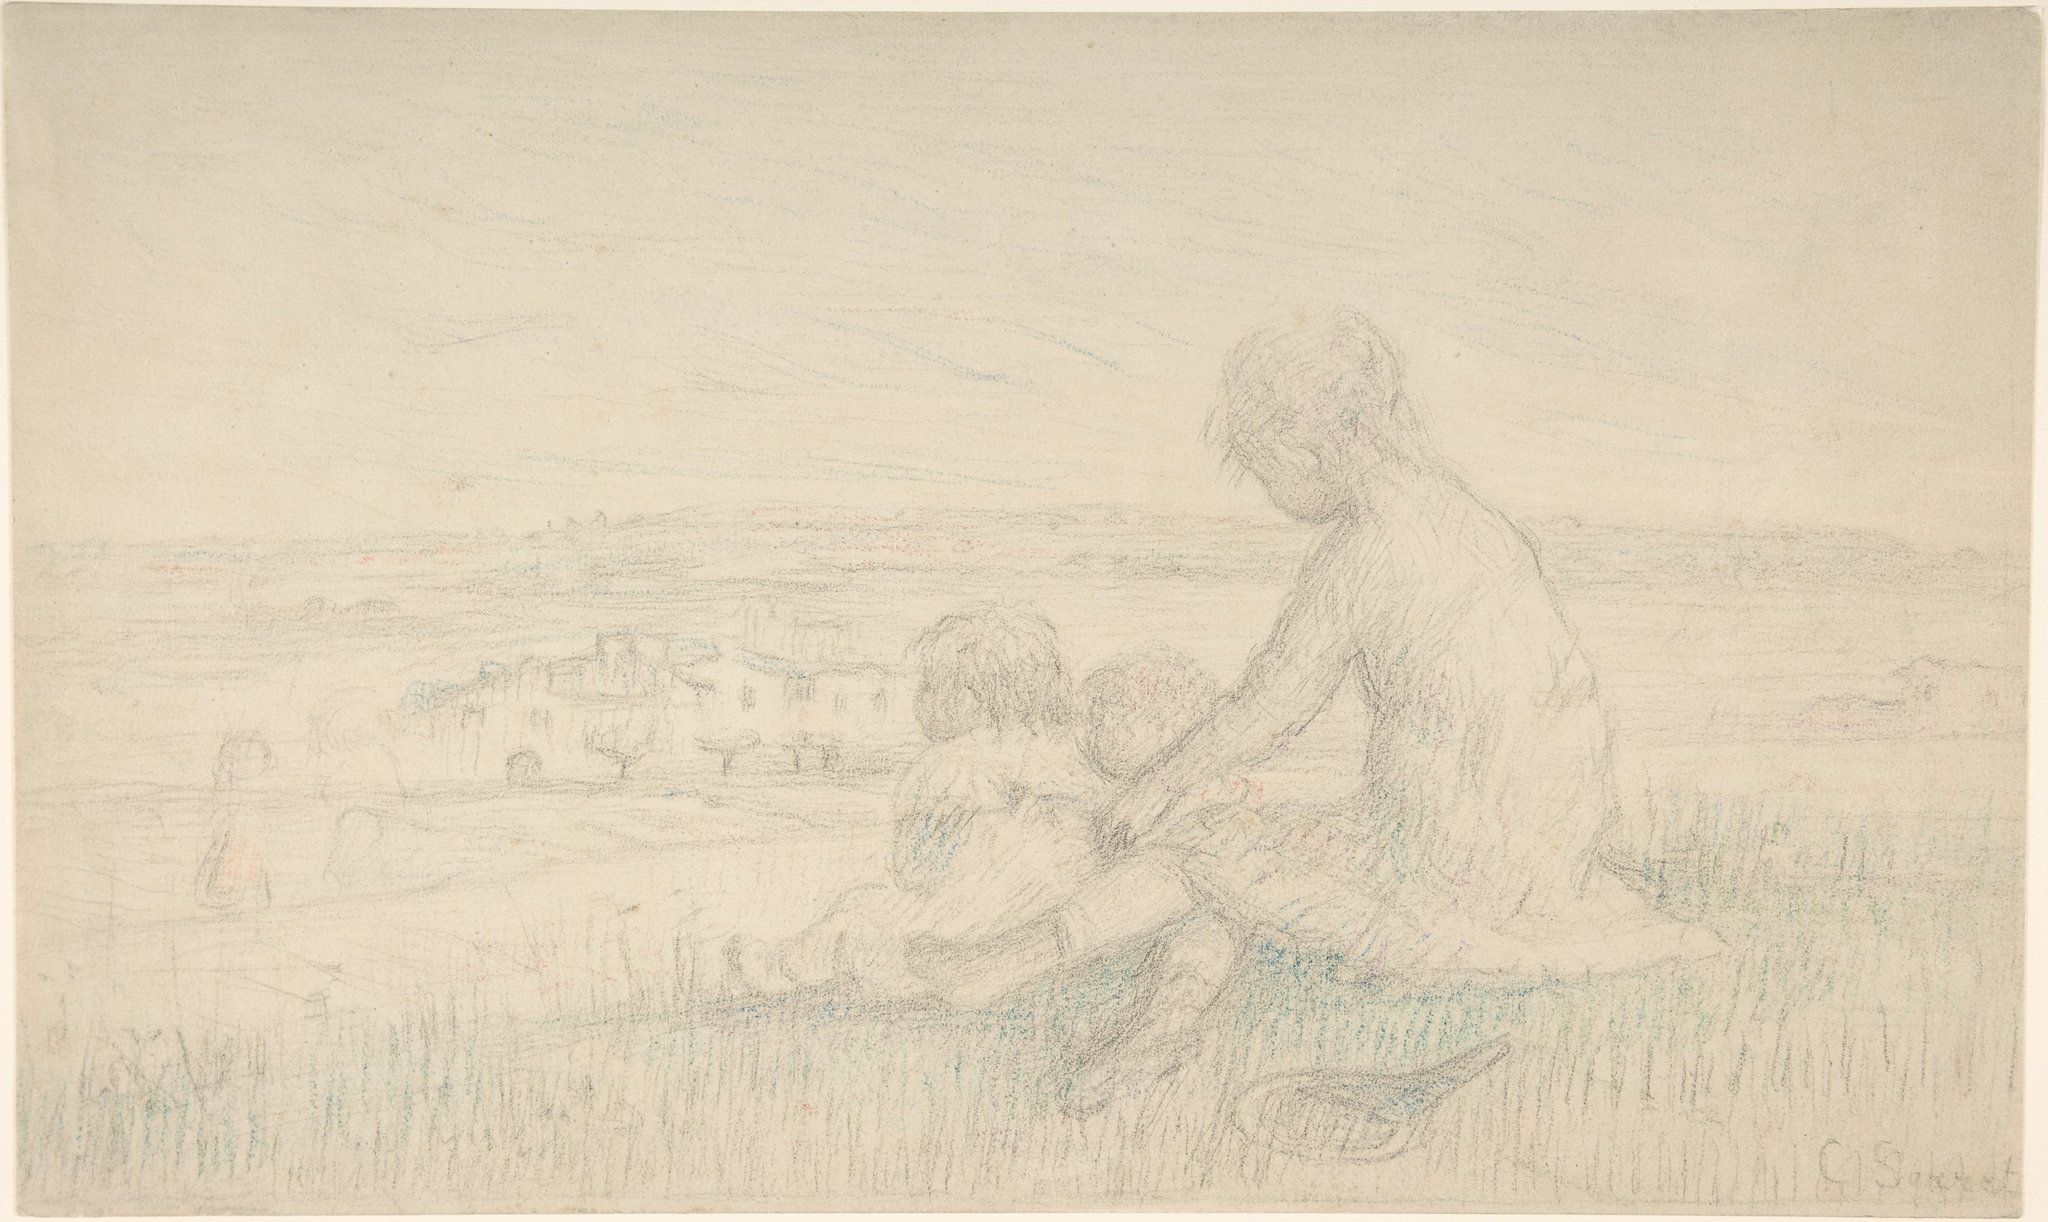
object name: drawing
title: Children Seated on a Hillside with a Racquet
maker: charles-emmanuel serret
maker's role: artist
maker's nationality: french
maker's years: 1824-1900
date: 1801-1900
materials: chalk, pastel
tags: children,landscapes